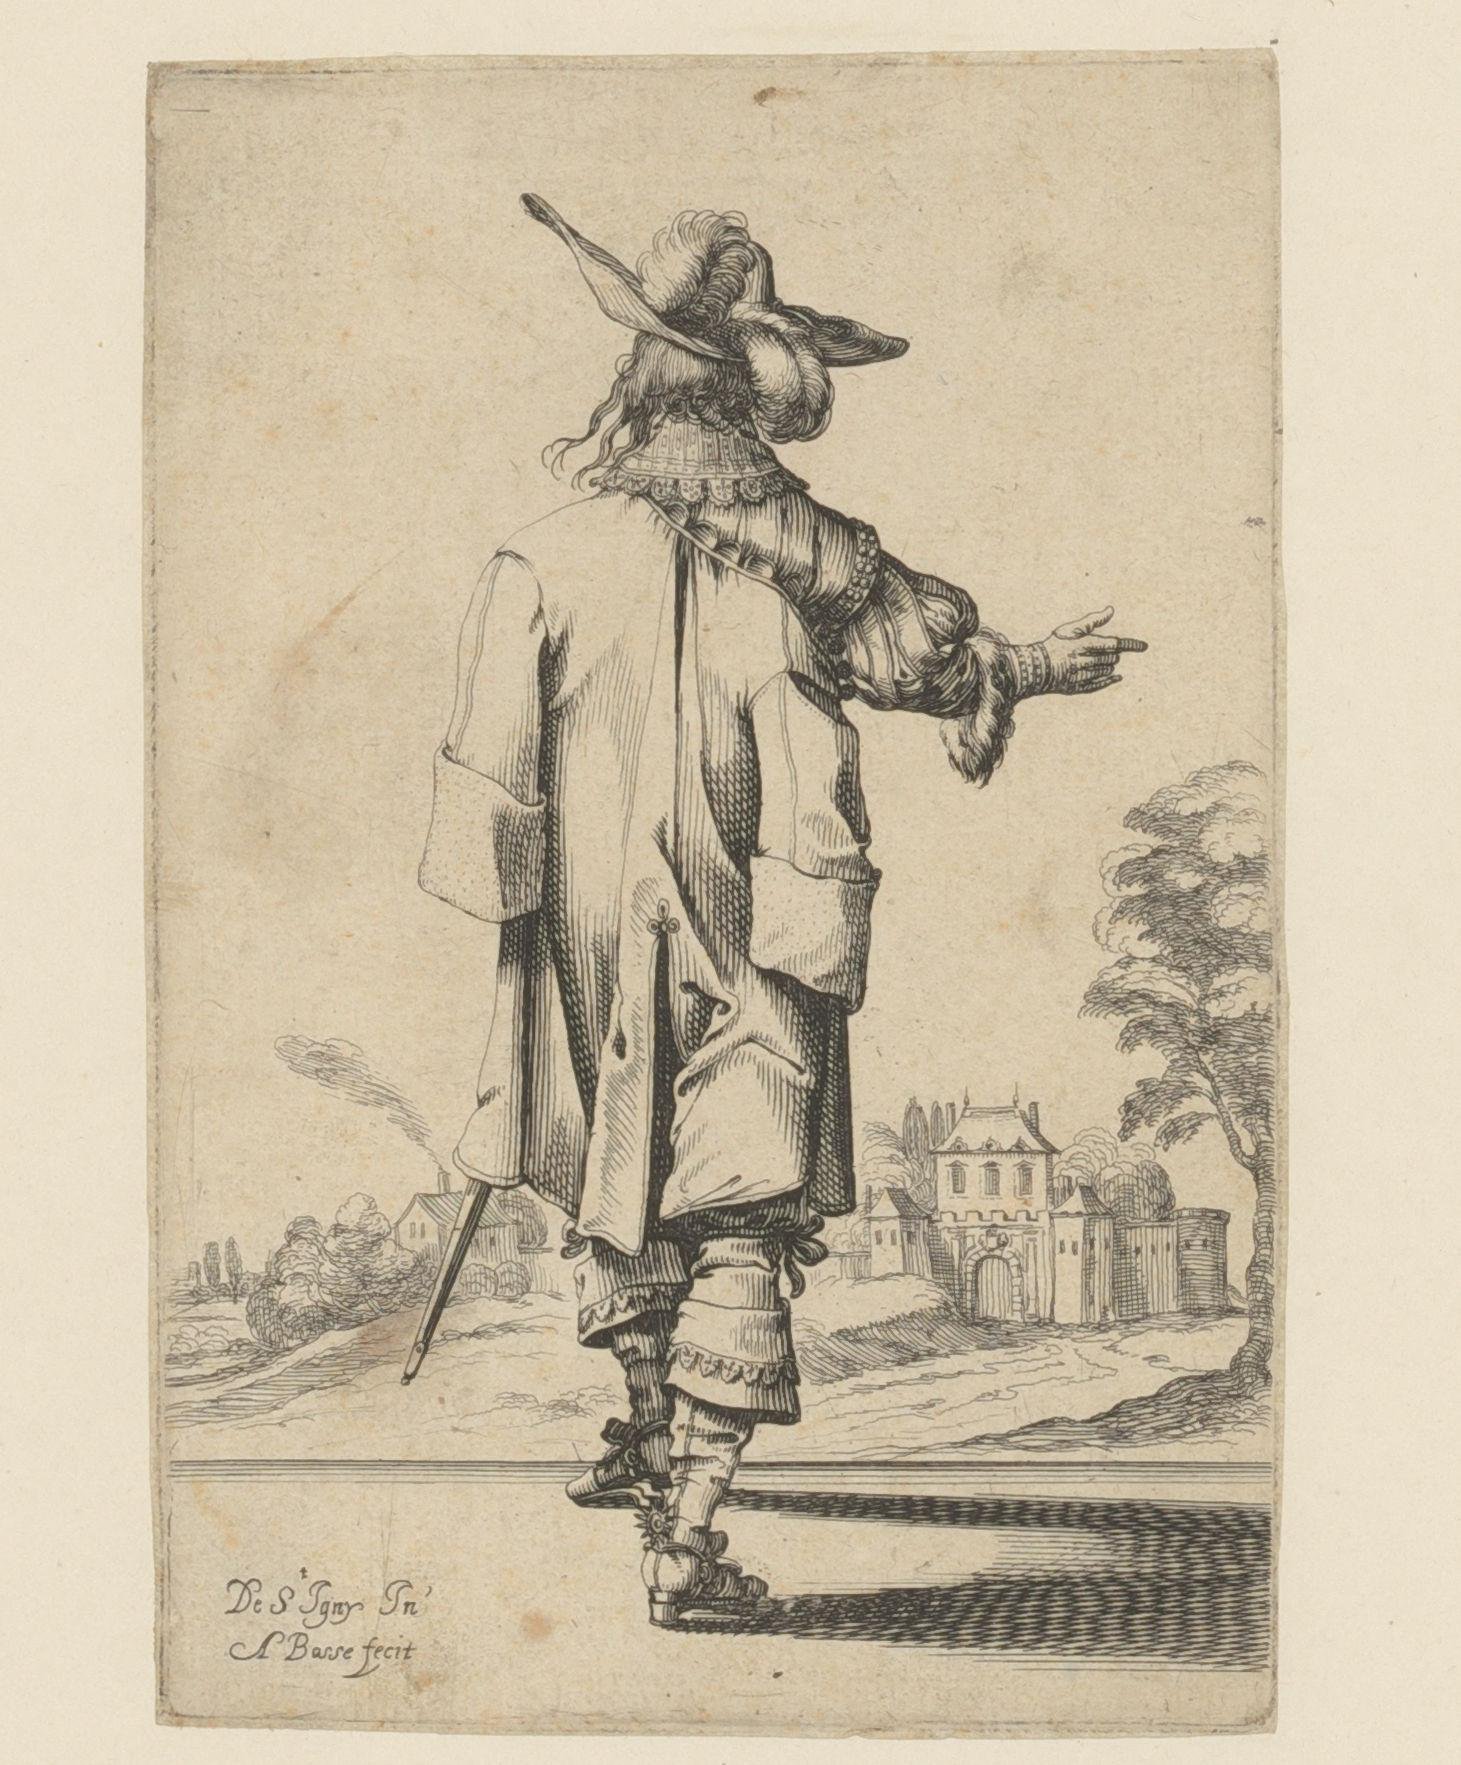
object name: print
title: Franse edelman, op de rug gezien, gekleed volgens de mode van ca. 1630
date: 1629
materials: paper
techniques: etching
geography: paris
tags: sleeves (+ fur used for clothes), coat (+ men's clothes), head-gear: hat (+ men's clothes), styles of hairdress, europeans (with name), shoes, sandals (+ men's clothes), clothes, costume (+ men's clothes), shoes, sandals, trousers, breeches, etc. (breeches) (+ men's clothes), hacking and thrusting weapons (foil), sleeves (+ men's clothes), head-gear: hat (+ feathers used for clothes)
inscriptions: stamp, stamp, collector's mark: Lugt 1641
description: Lopende edelman op de rug gezien, gekleed in een halflange mantel die over zijn linkerschouder hangt. Daaronder een vest met brede pofmouwen, afgezet met bont (rechterarm) en een kuitbroek. Op zijn hoofd een hoed met brede rand en pluim en hij draagt schoenen met overschoenen. Met de rechterhand een wijzend gebaar. Onderwerpsrubrieken binnen de Atlas Zeden en Gewoonten: Zeden en Gewoonten in Engeren Zin, De Kleeding, Kleederdrachten (tijdvakken), Het begin der 17de eeuw. (De Fransche mode).